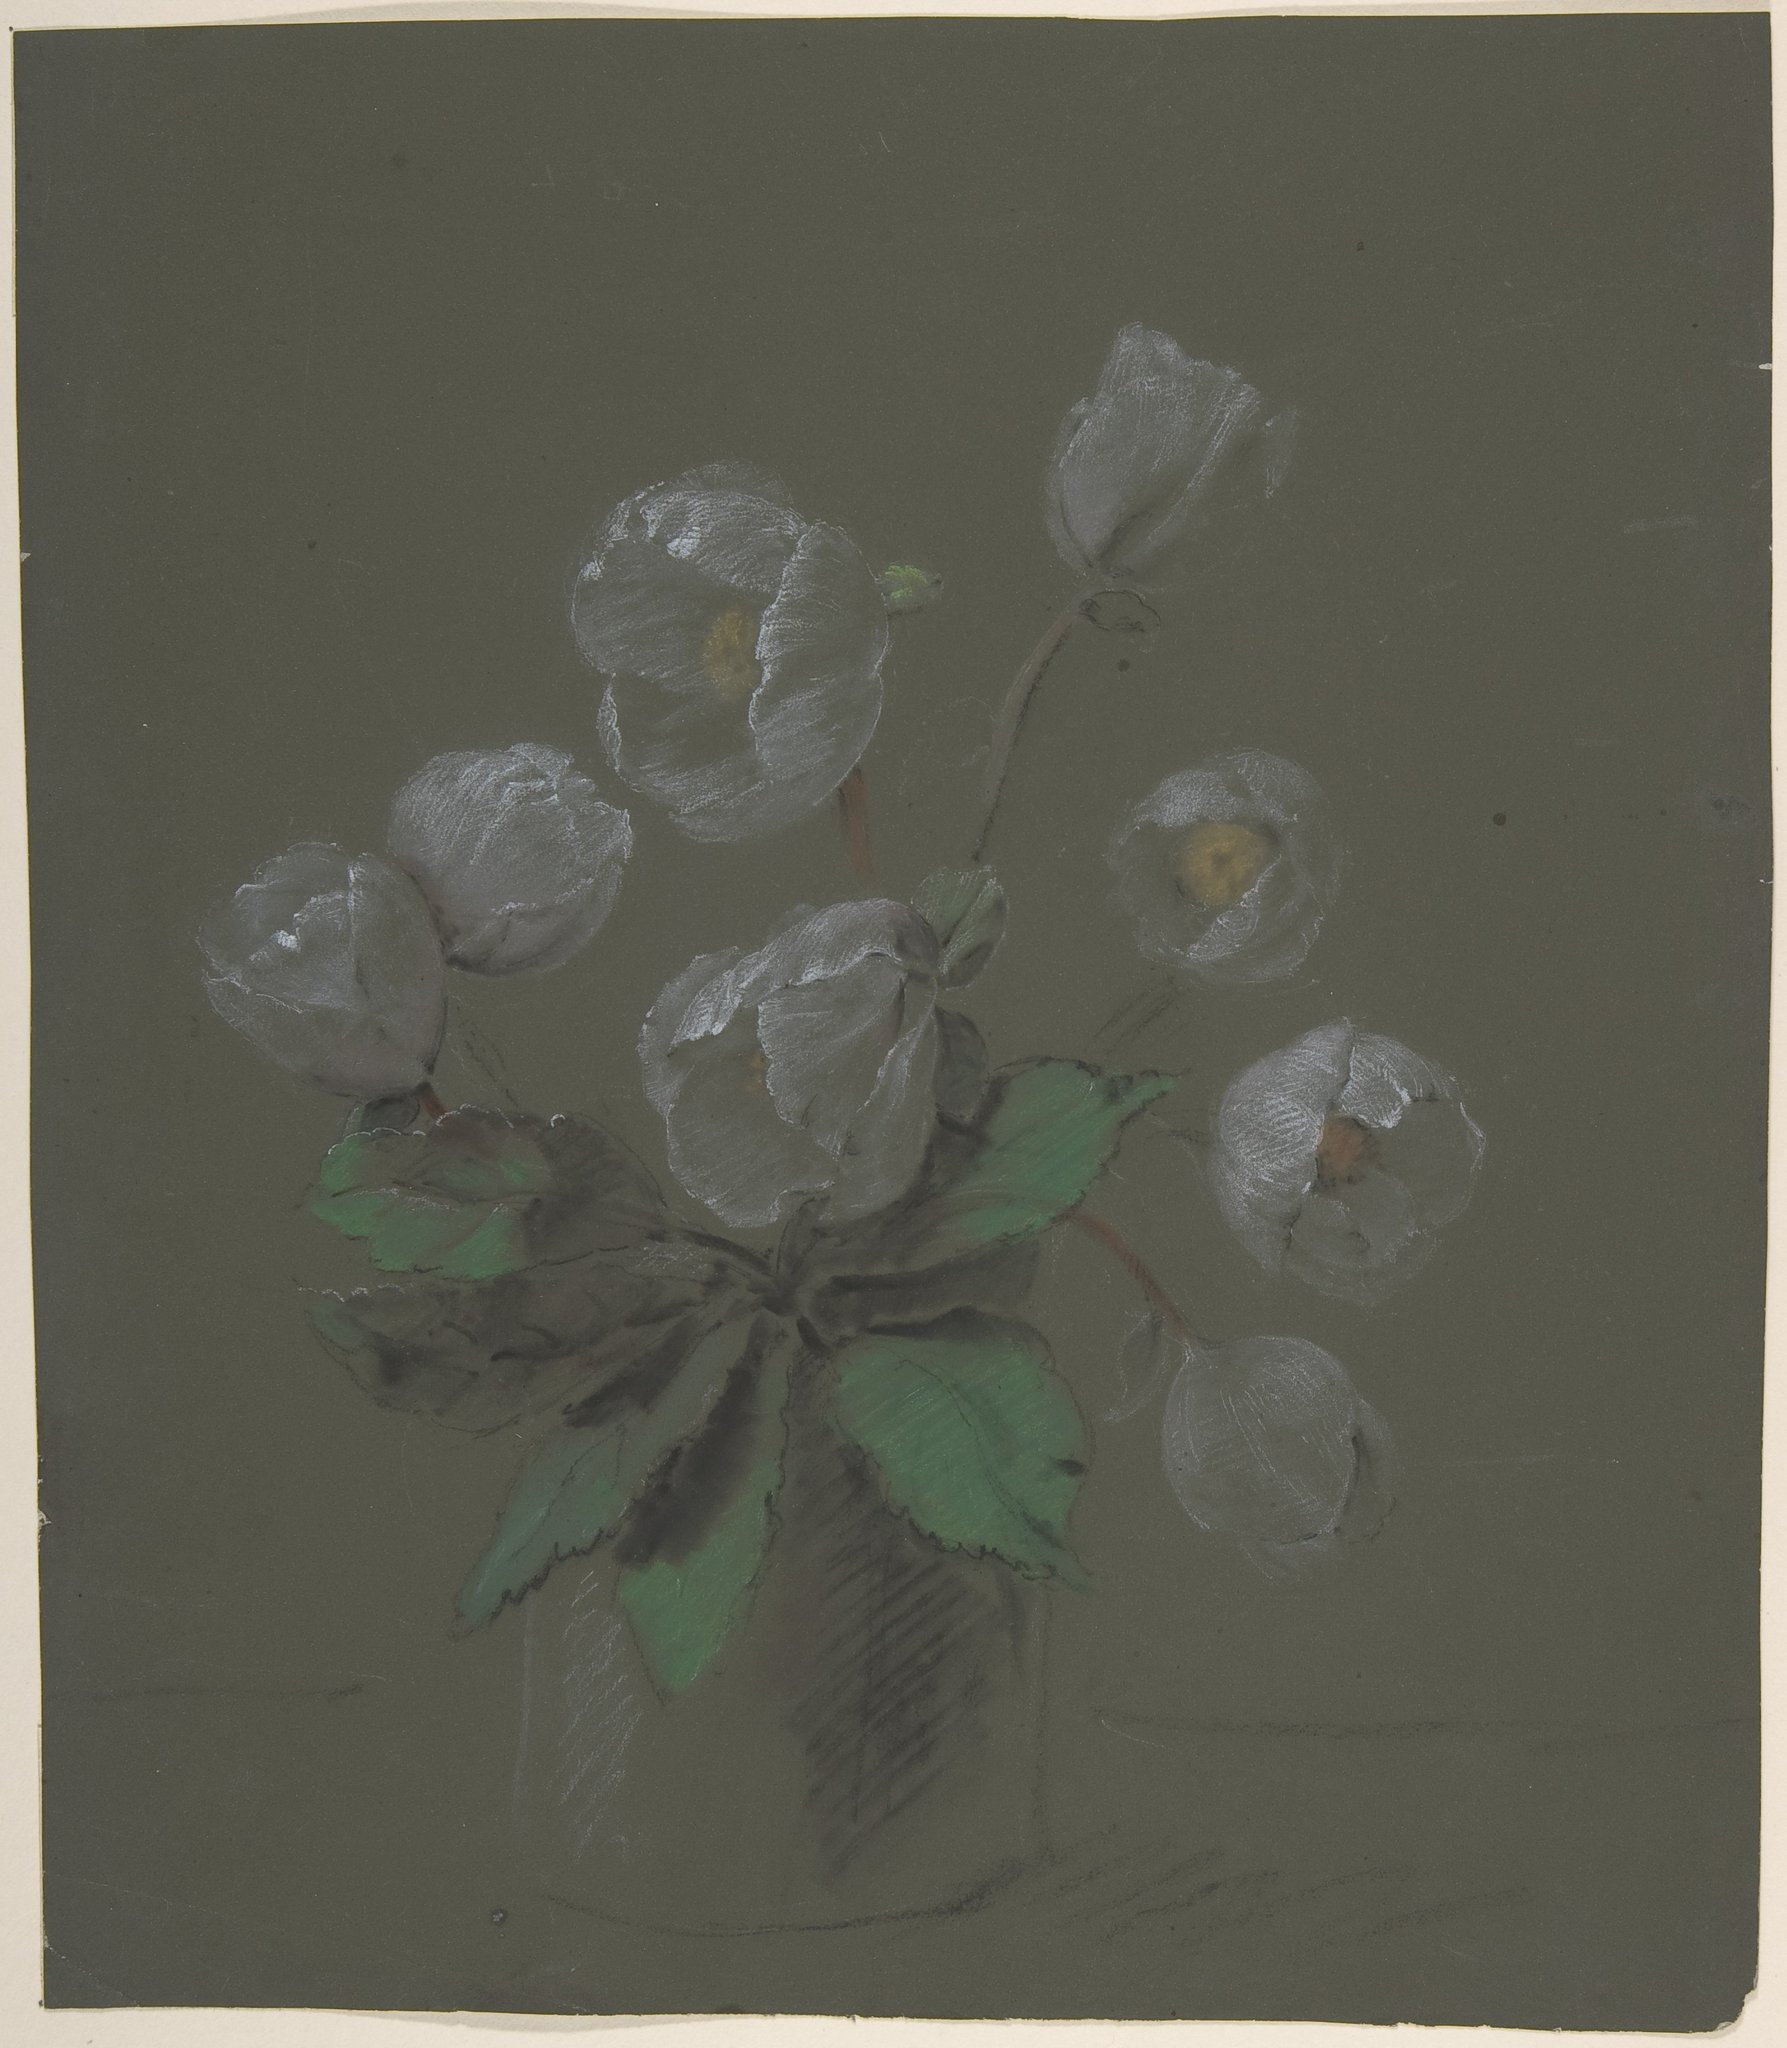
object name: drawing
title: Floral Design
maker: antoine berjon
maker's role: artist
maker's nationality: french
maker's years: 1754-1843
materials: chalk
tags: flowers